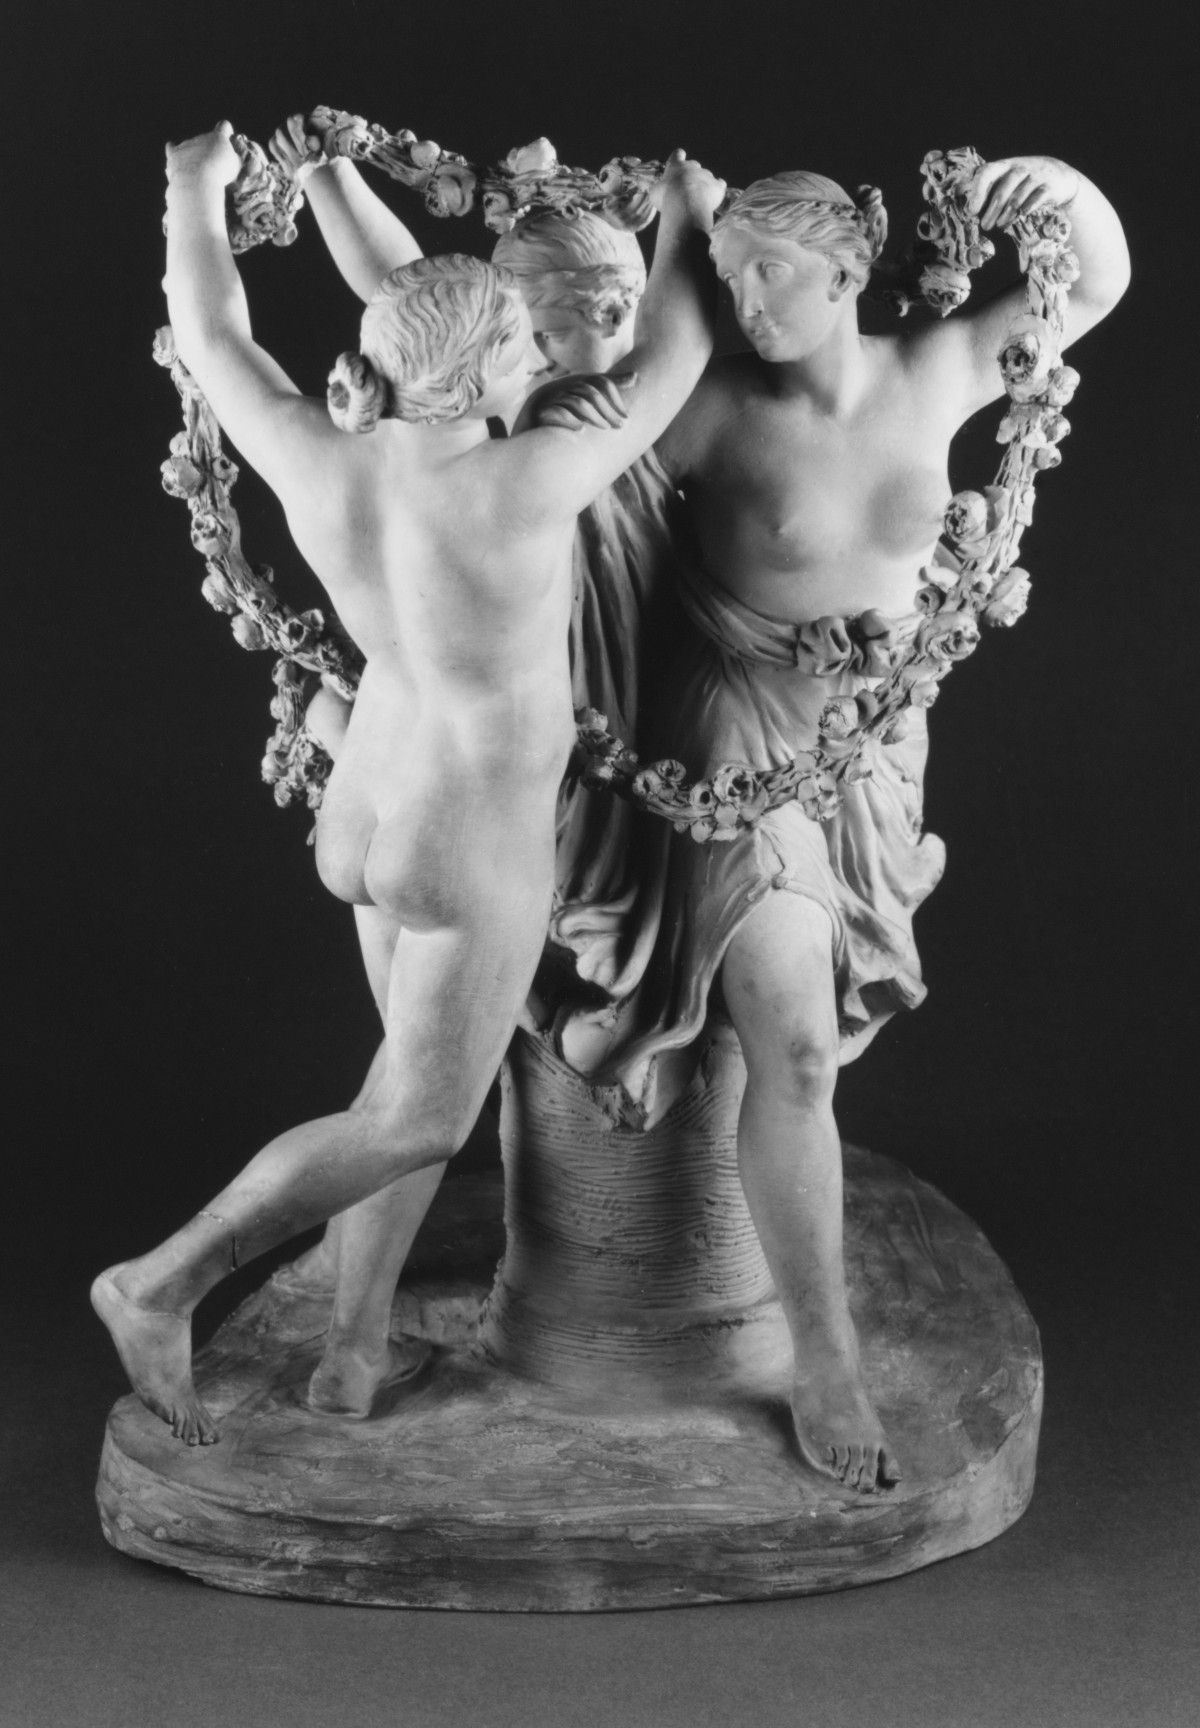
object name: statuette group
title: The Three Graces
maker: bartolomeo pinelli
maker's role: maker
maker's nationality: italian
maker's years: 1781-1835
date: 1820-1830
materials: terracotta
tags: garlands,goddess